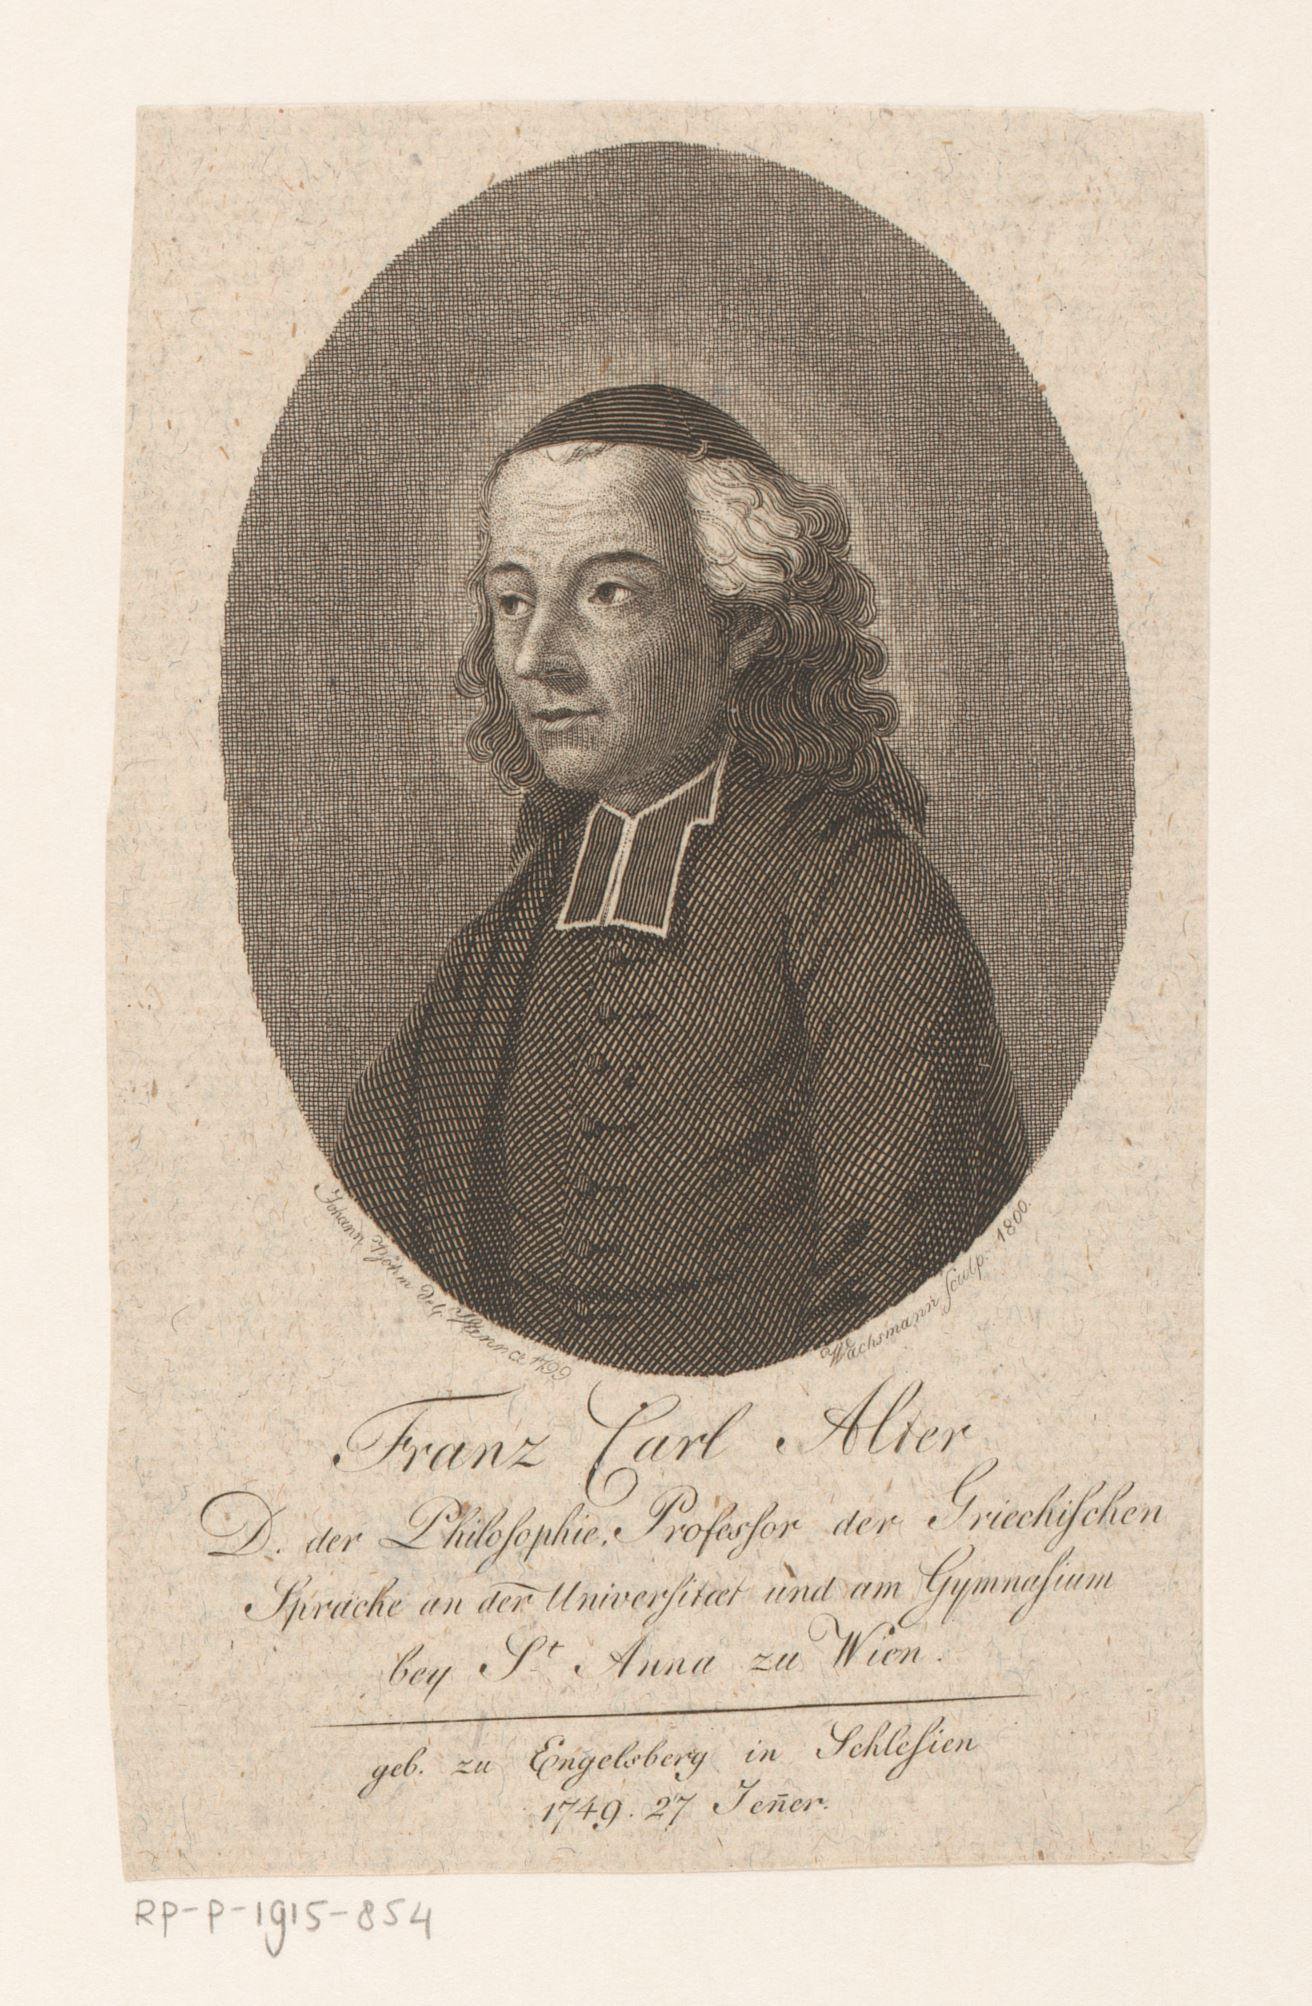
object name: print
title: Portret van Franz Carl Alter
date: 1800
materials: paper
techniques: engraving, etching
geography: germany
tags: historical persons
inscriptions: collector's mark: Lugt 2228